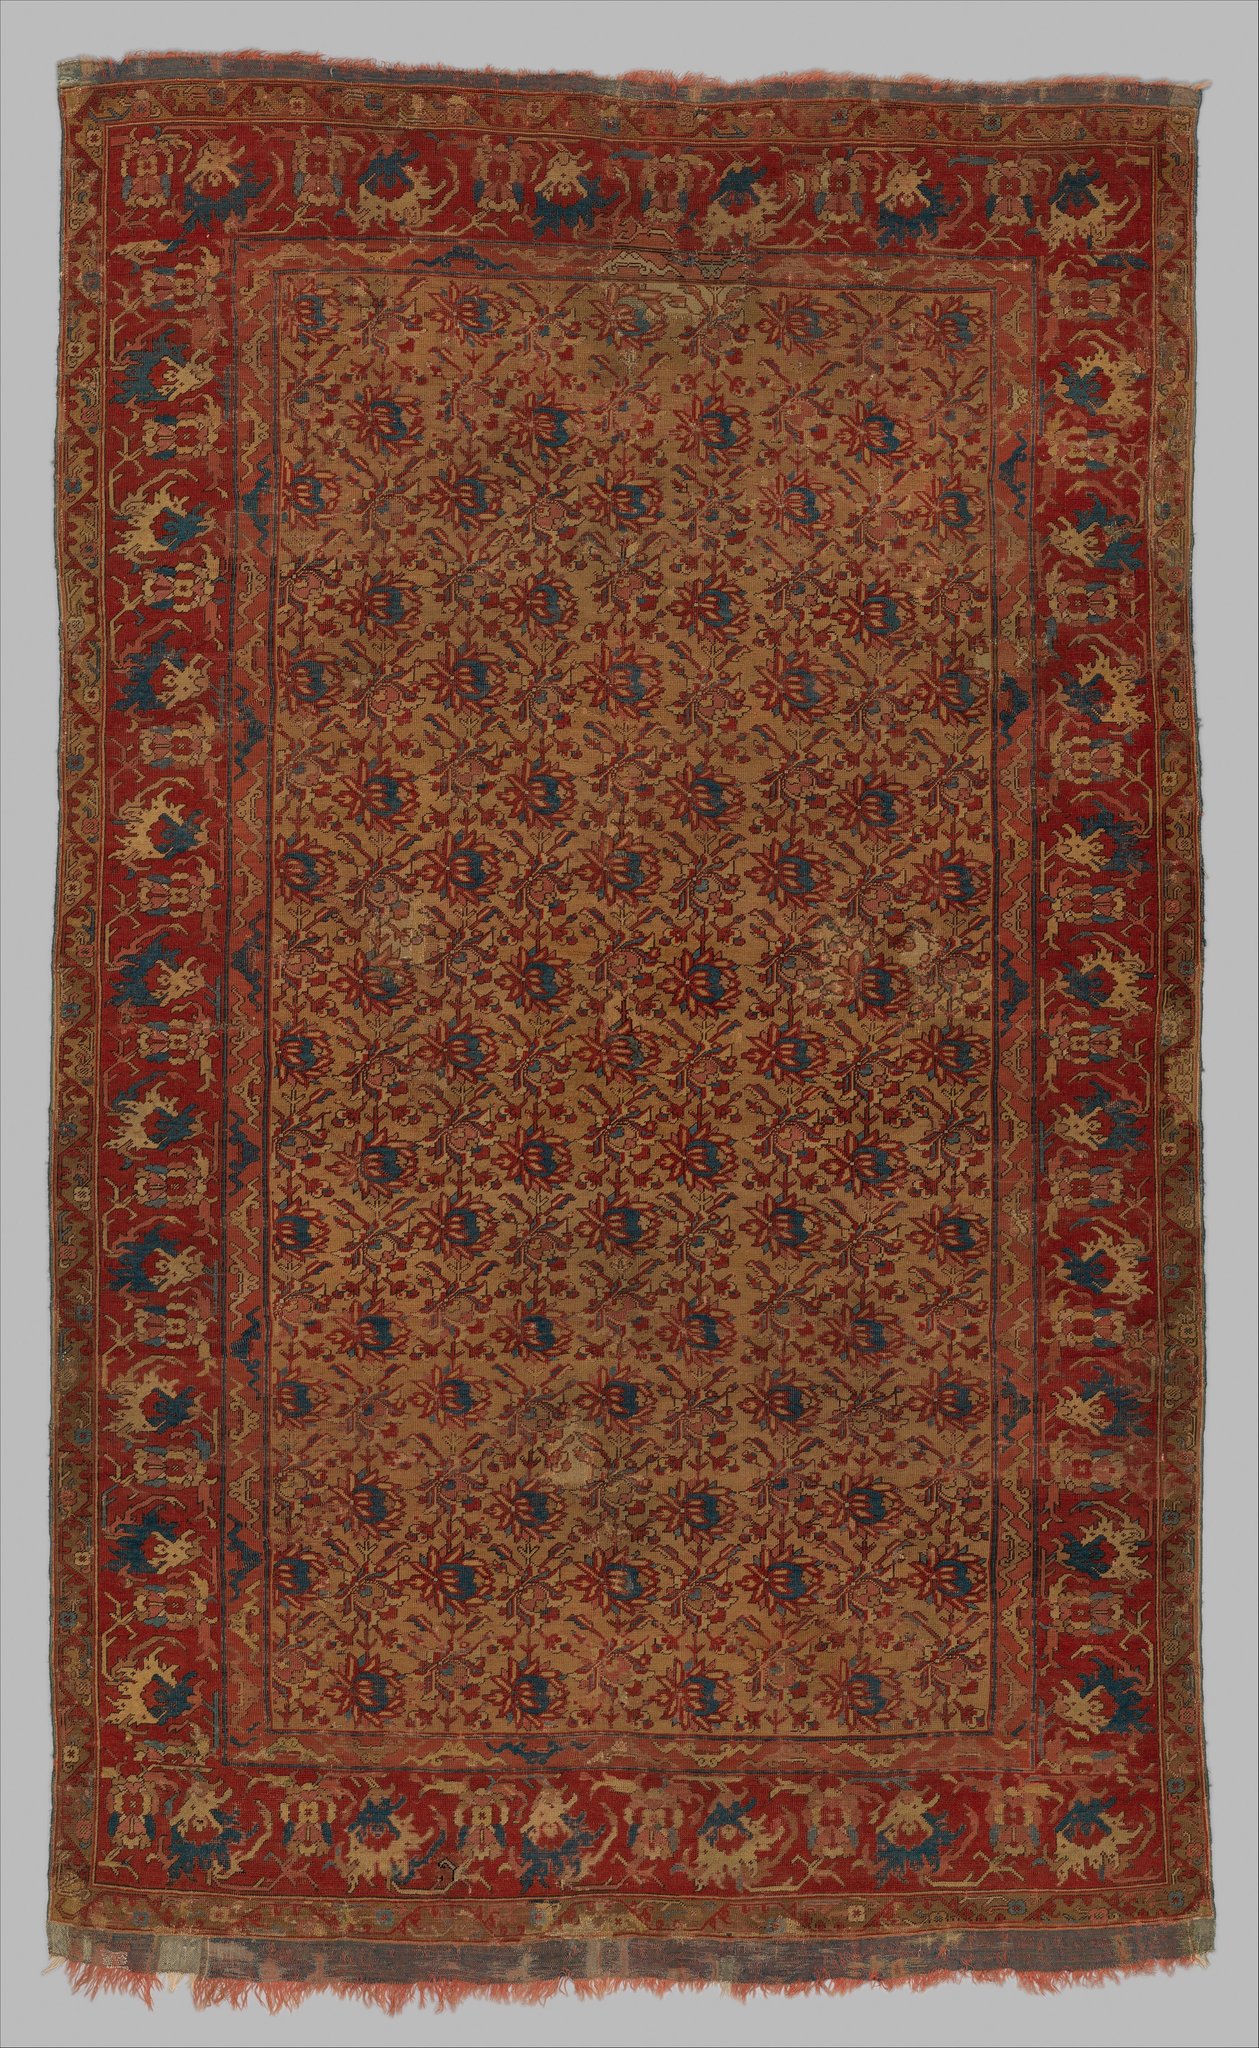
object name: carpet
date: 1667-1700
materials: wool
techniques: pile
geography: turkey